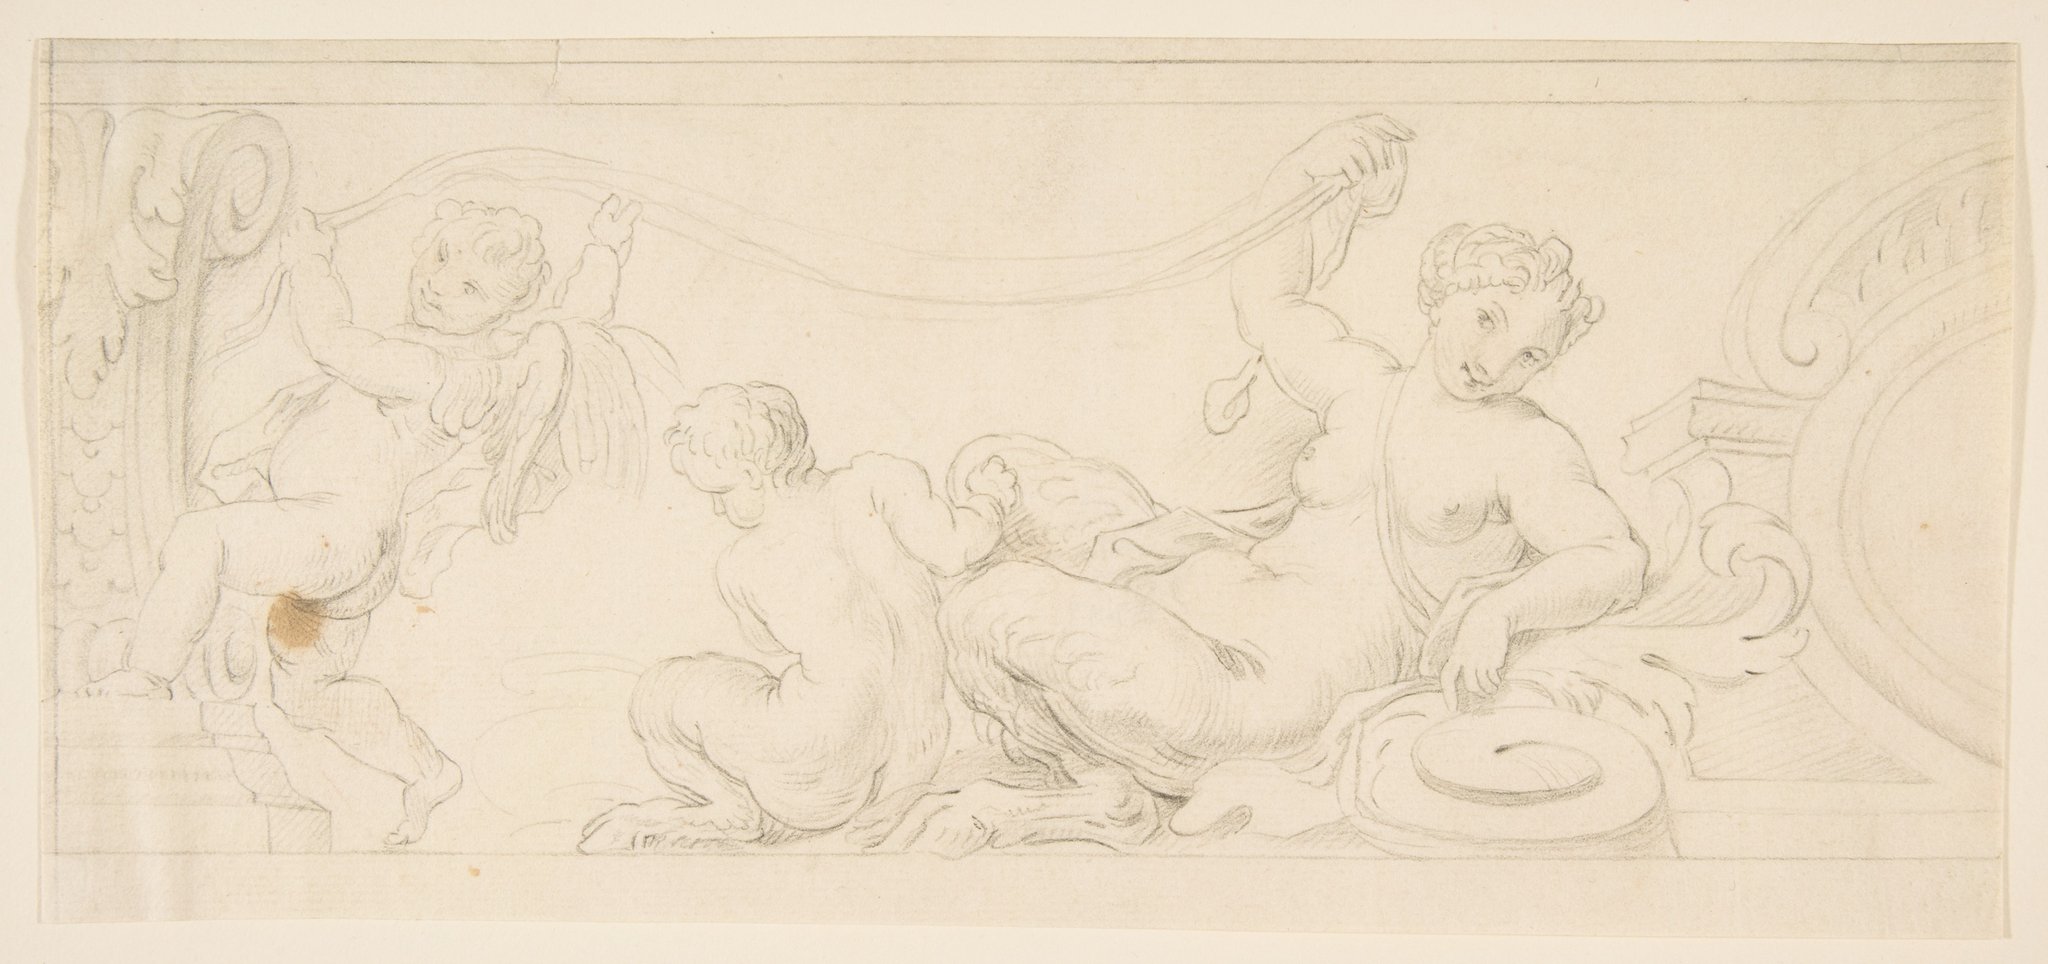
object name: drawing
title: Design for a Frieze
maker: anonymous, french, 18th century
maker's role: artist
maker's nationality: french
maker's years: 1700-1800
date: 1701-1800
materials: chalk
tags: female nudes,putti,satyrs